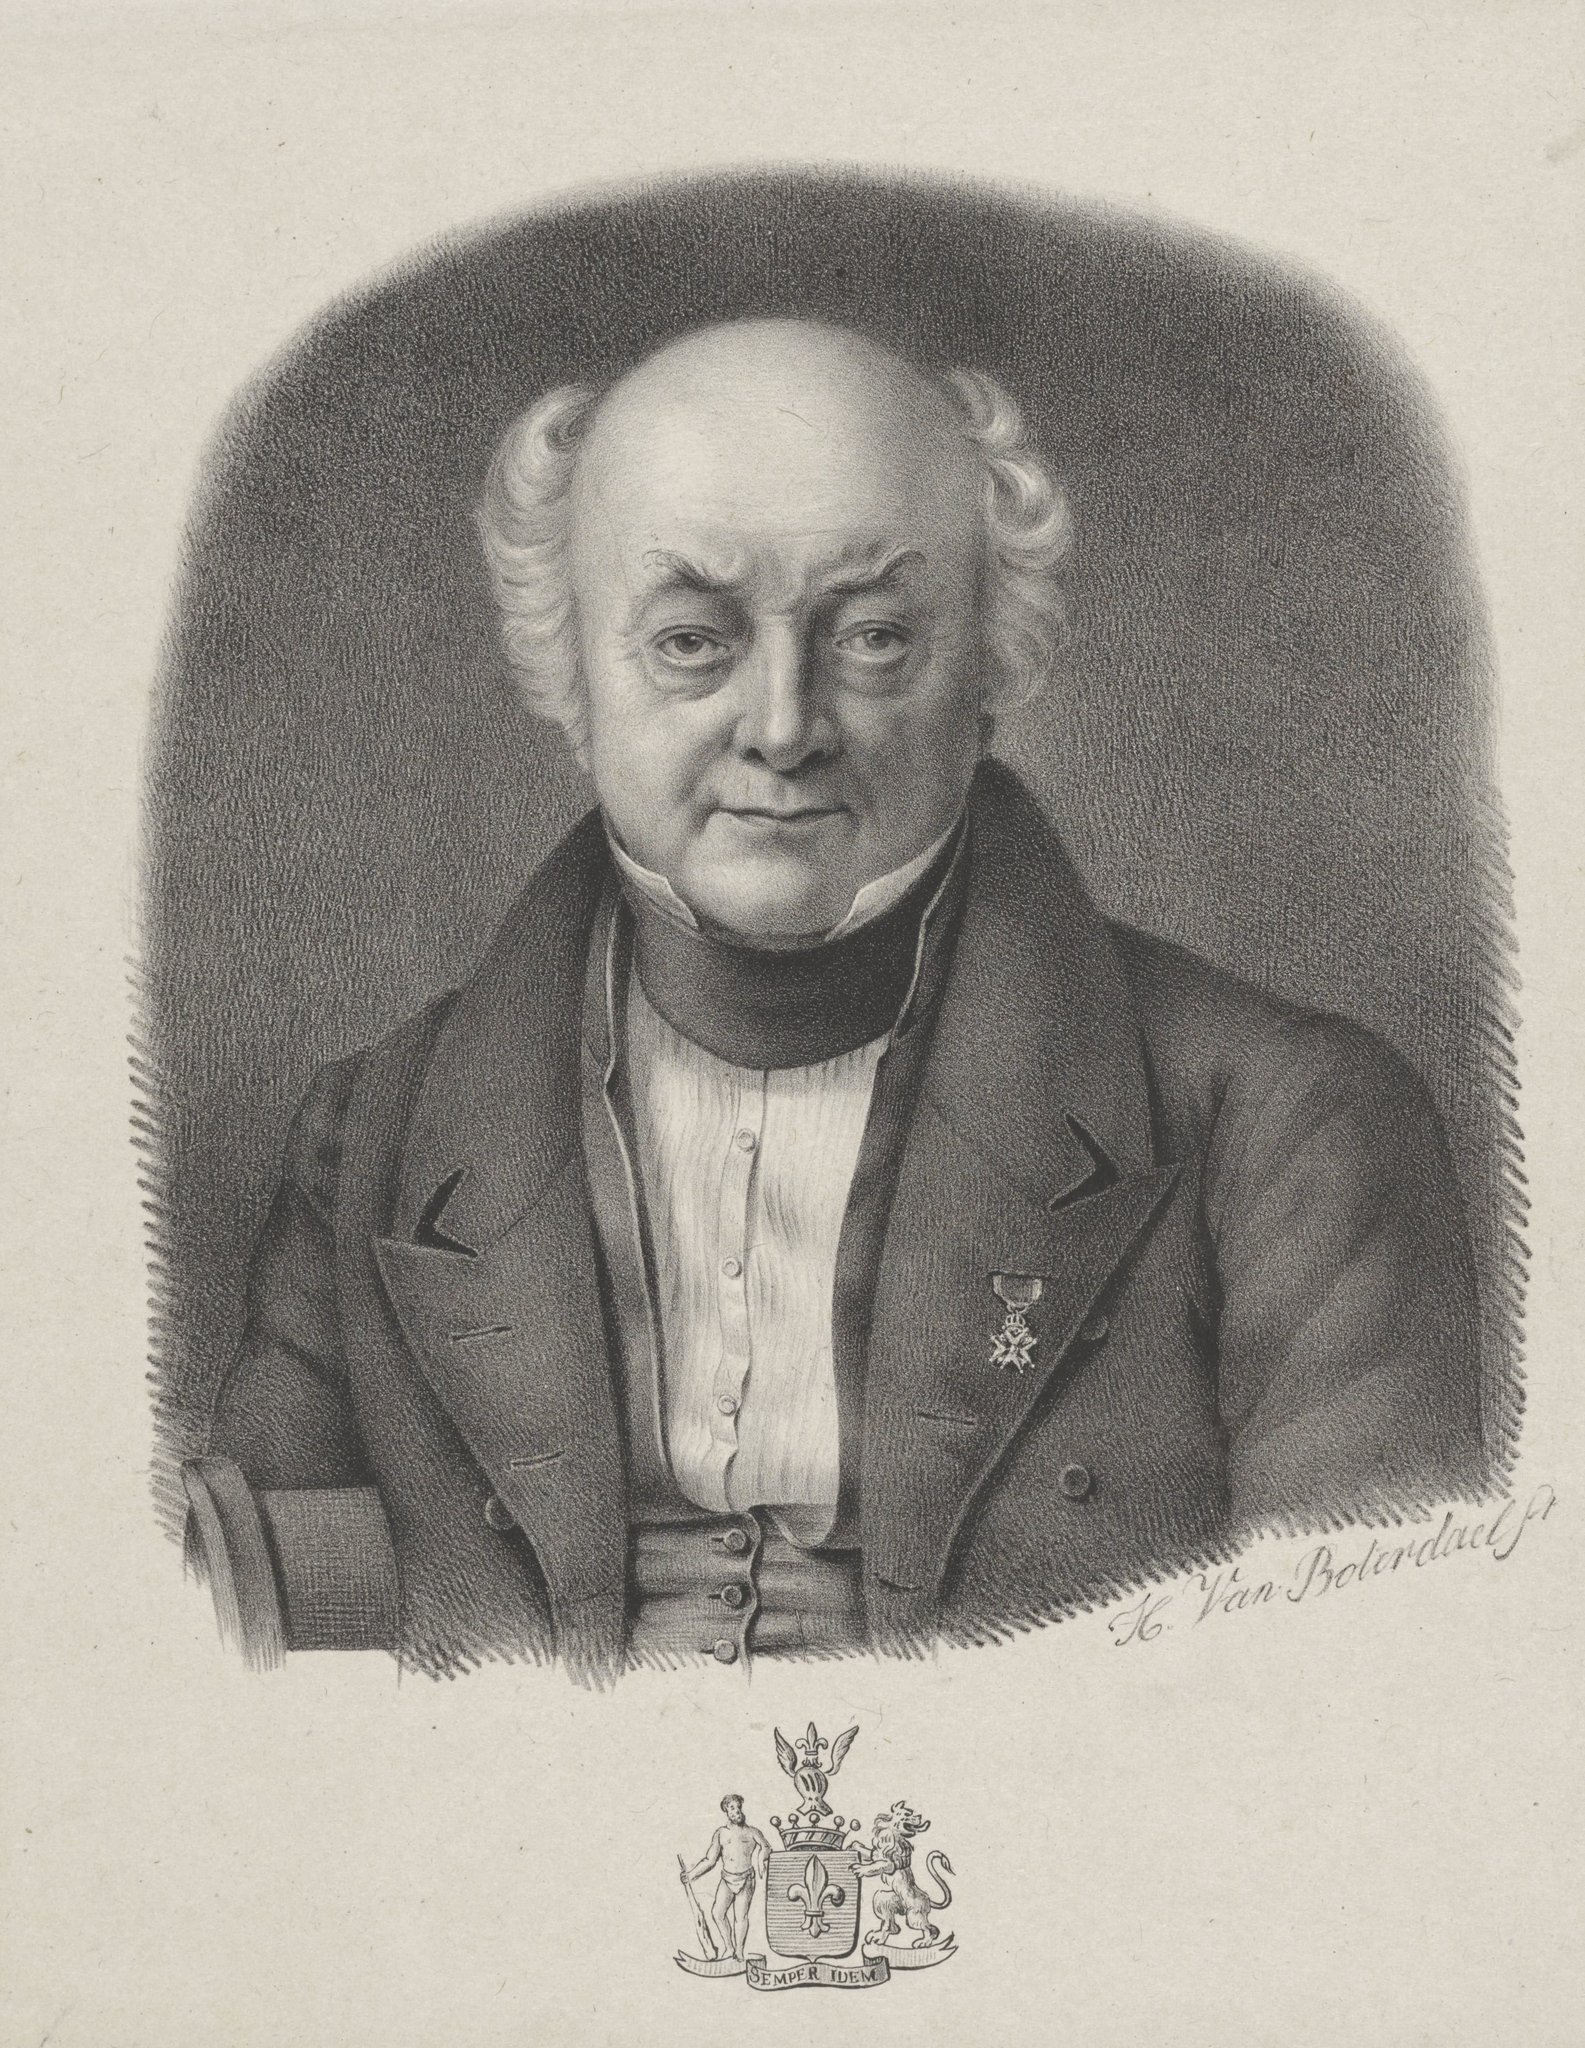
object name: print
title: Portret van Claudius Pieter Gevers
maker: h. van boterdael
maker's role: print maker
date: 1830-1836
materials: paper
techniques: lithograph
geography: rotterdam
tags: rotterdam, leiden, politician, knighthood order, historical persons, armorial bearing, heraldry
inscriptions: collector's mark: Lugt 2760, collector's mark: Lugt 2228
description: De geportretteerde draagt de Orde van de Nederlandse Leeuw op de revers van zijn jas. Onder het portret het familiewapen van de familie Gevers met een wildeman, leeuw, fleur de lis en erboven een kroon en helm.